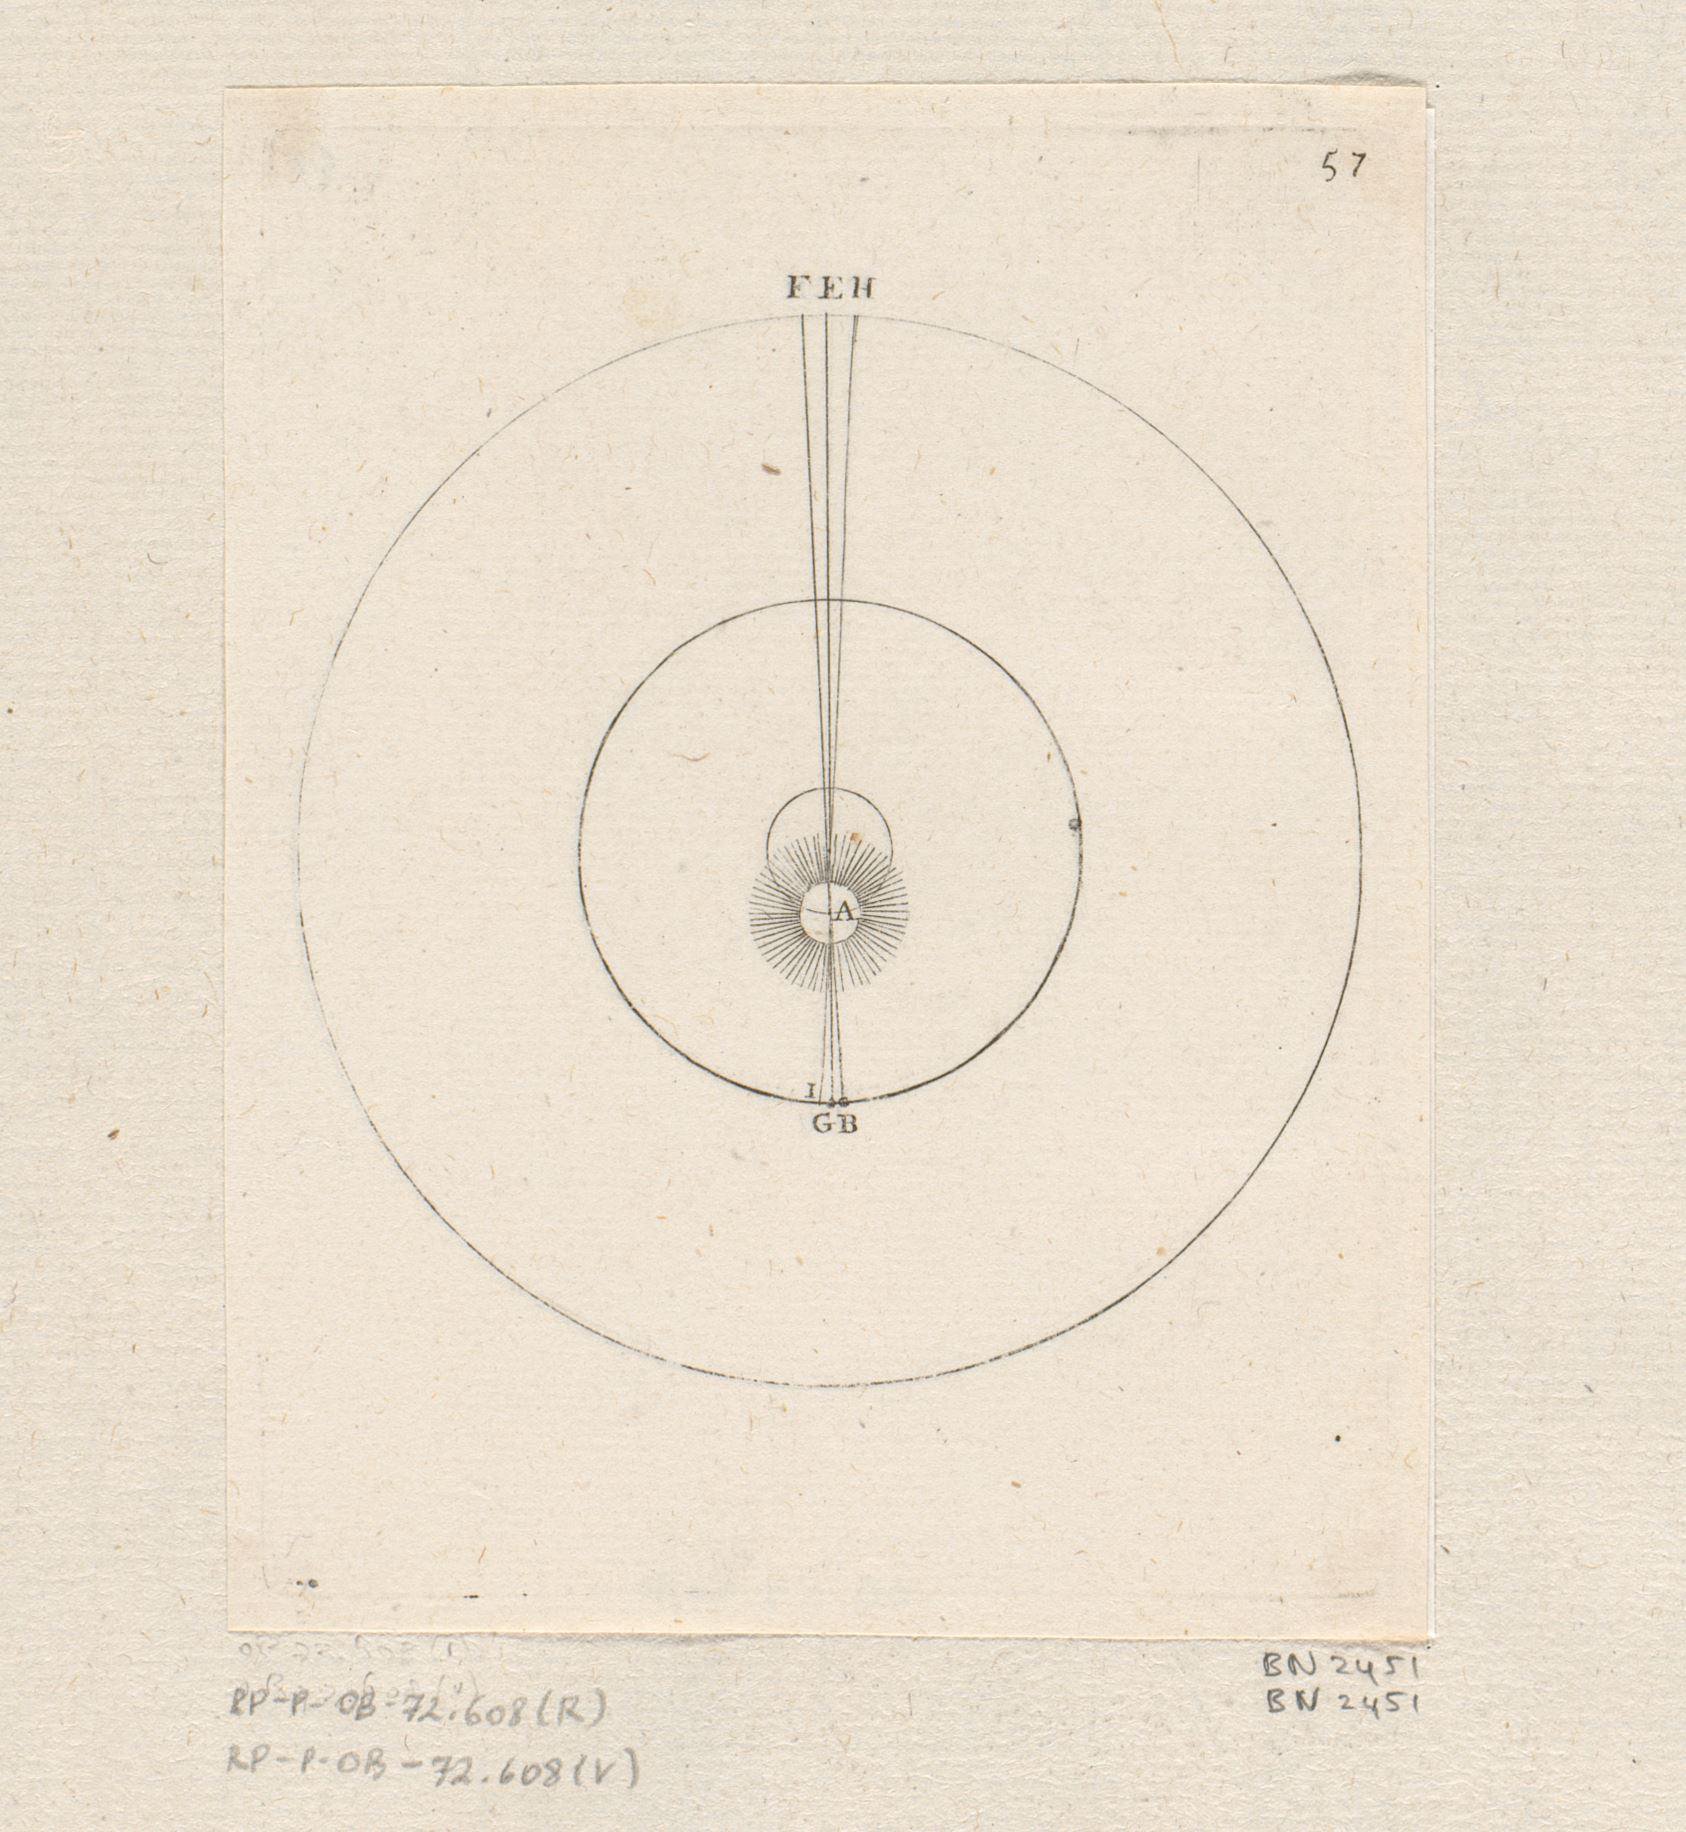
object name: print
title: Zon bij het perigeum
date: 1706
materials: paper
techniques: etching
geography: france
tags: earth, world as celestial body, sun as celestial body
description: Prent uit: Leclerc, Sébastien. Nouveau systeme du monde conforme à l'Ecriture sainte. Où les phénomènes sont expliquez sans excentricité de mouvement (...). Paris: Pierre Giffart, 1706.